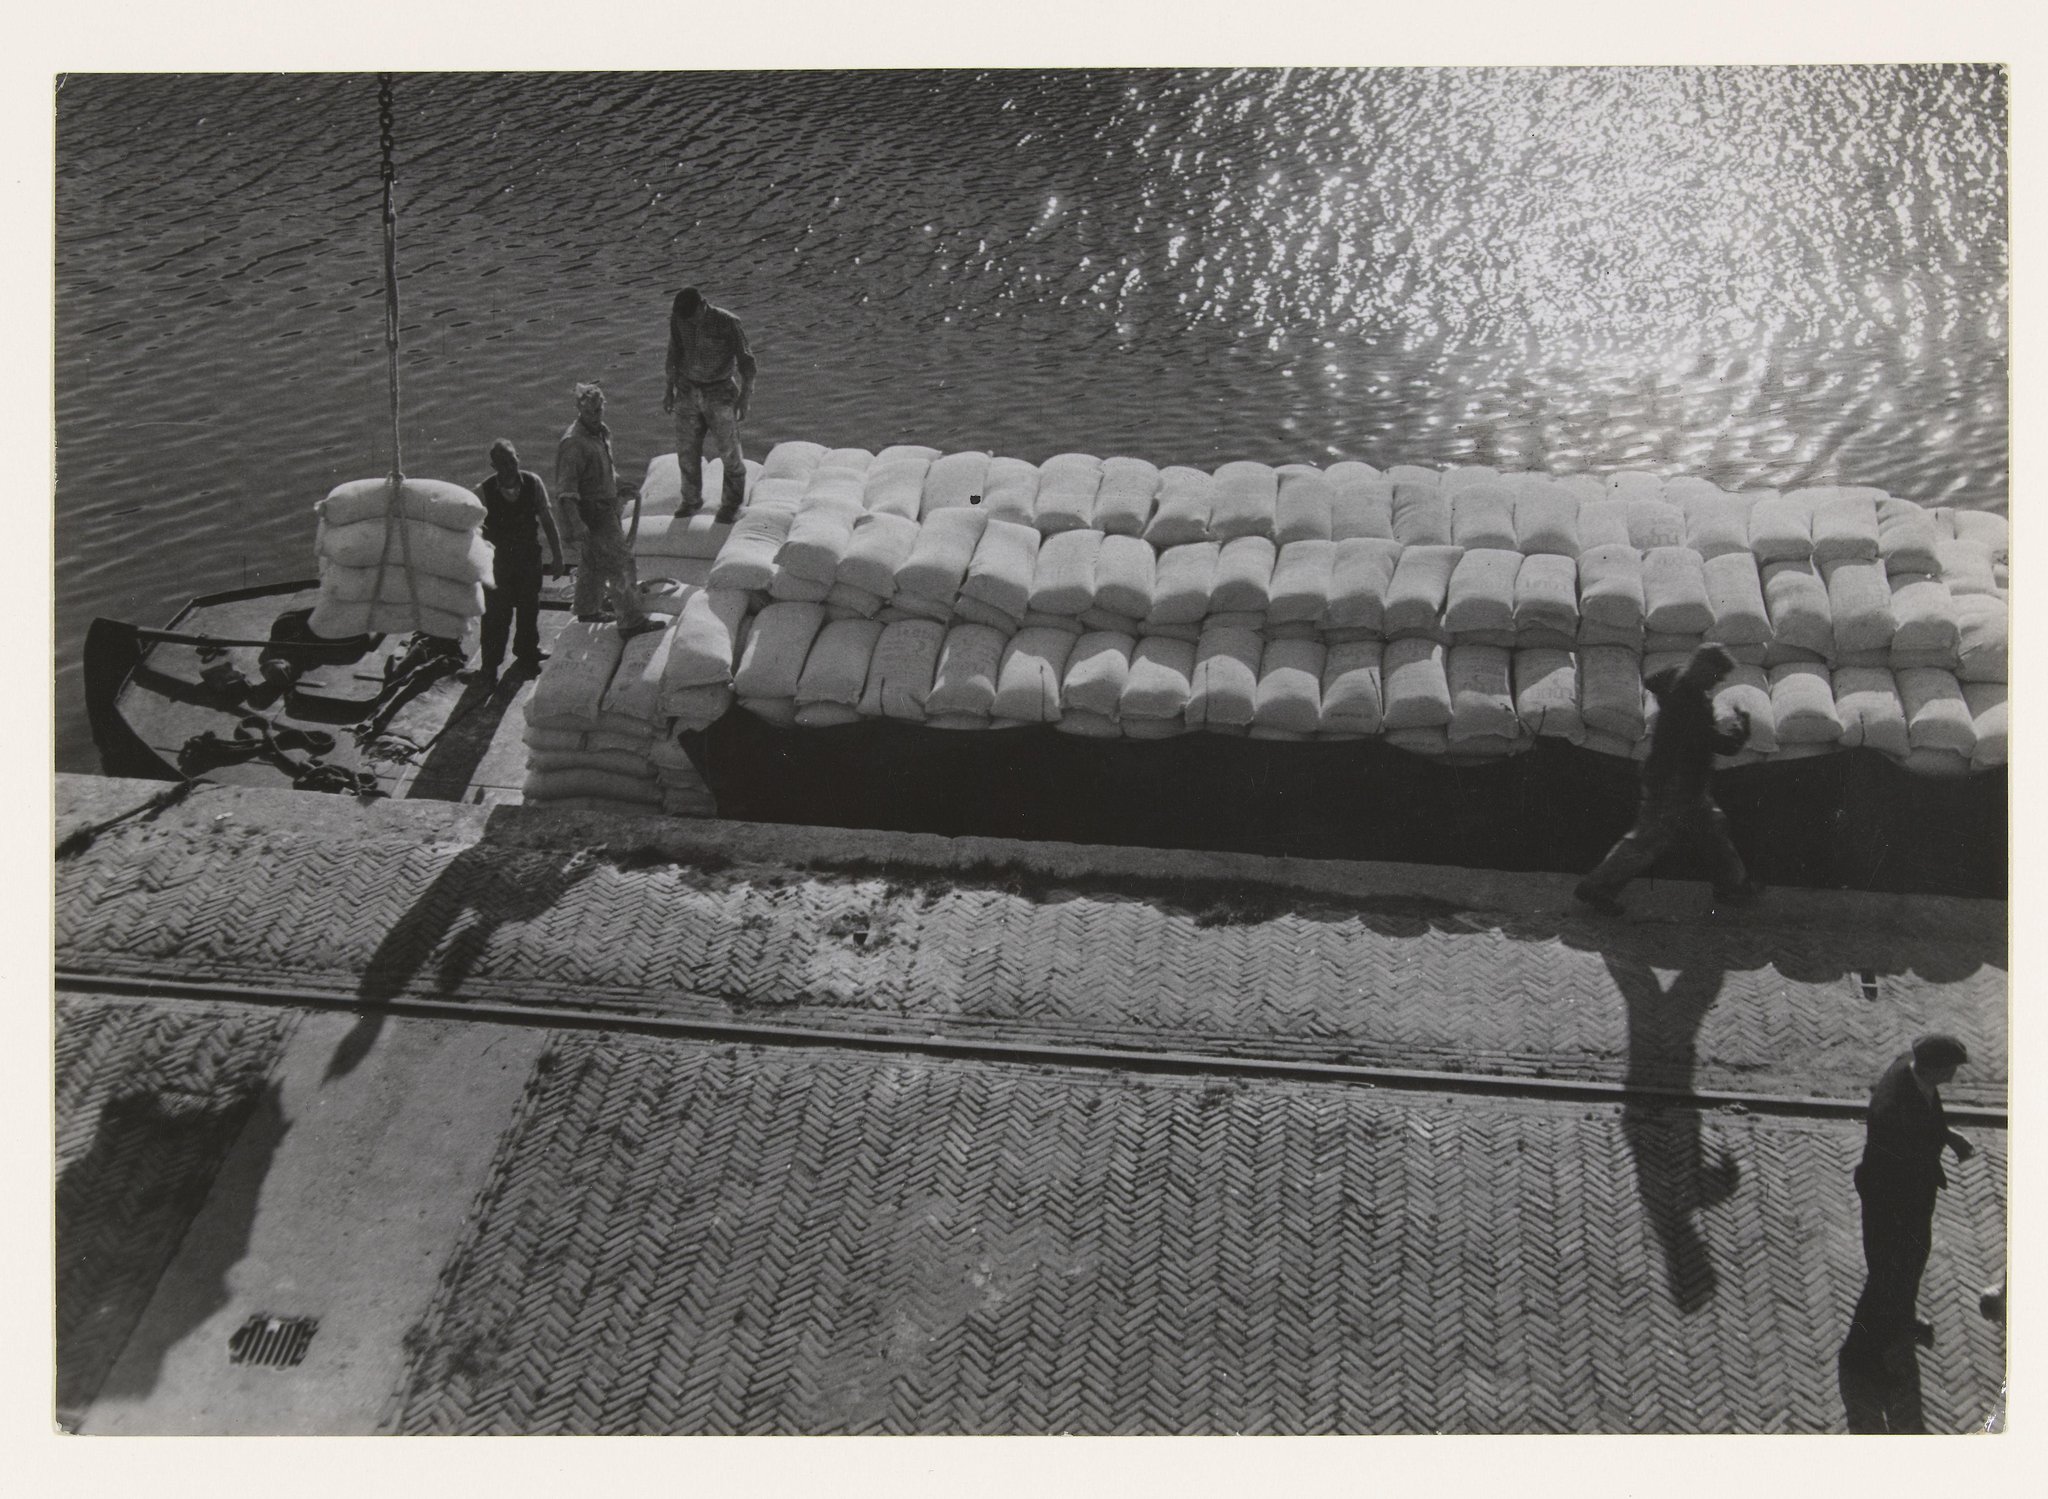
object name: documentary photograph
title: Geallieerde voedselhulp: het lossen van een dekschuit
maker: theo van haren noman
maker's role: cineast, fotograaf, regisseur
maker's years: 1917-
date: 1910-1945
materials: photographic support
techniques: photography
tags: publisher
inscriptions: number: ‘9380’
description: Aan een kade in de Rotterdamse (?) haven wordt een volle dekschuit, beladen met zakken gelost door een drietal havenarbeiders. De eerste zakken worden van de dekschuit gehesen tegen de achtergrond van het water en met op de voorgrond de kade met enkelspoor. De dekschuiten voeren van de geallieerde 'Liberty' vrachtschepen naar de pakhuizen waar het voedsel uit Engeland en Amerika werd opgeslagen.